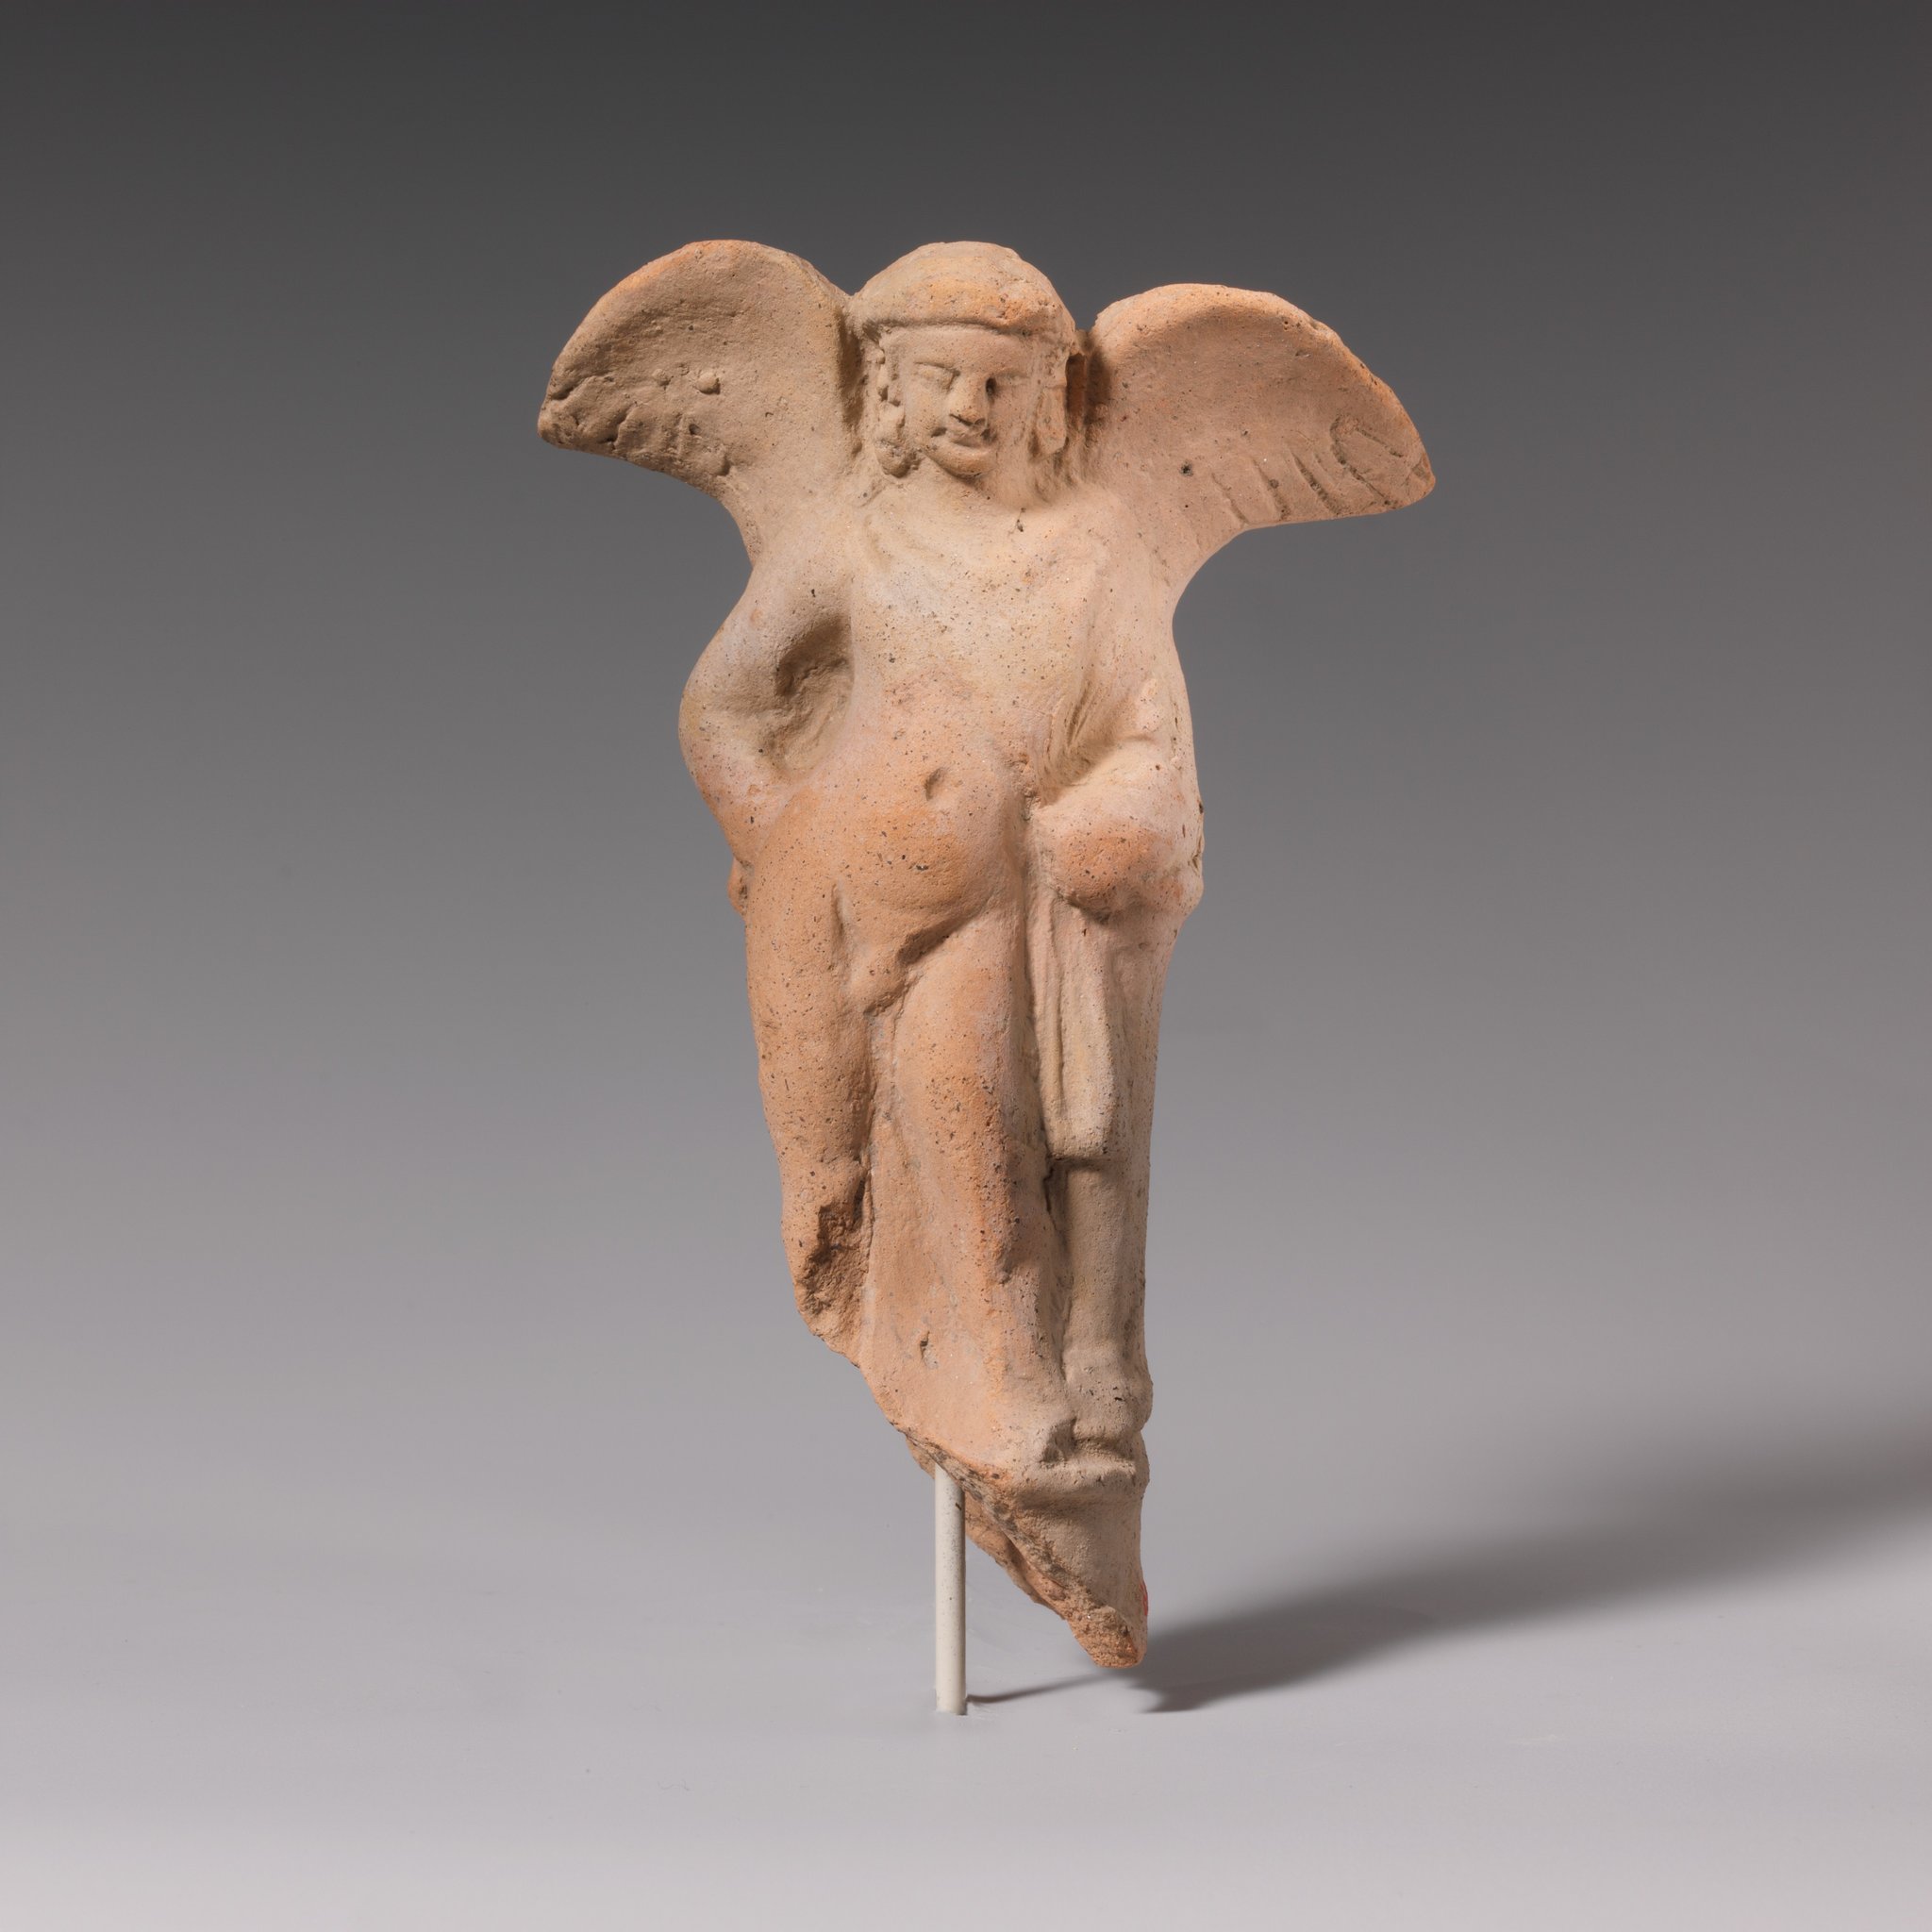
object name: statuette of eros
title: Terracotta statuette of Eros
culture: greek or south italian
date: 300-201 BCE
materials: terracotta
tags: eros